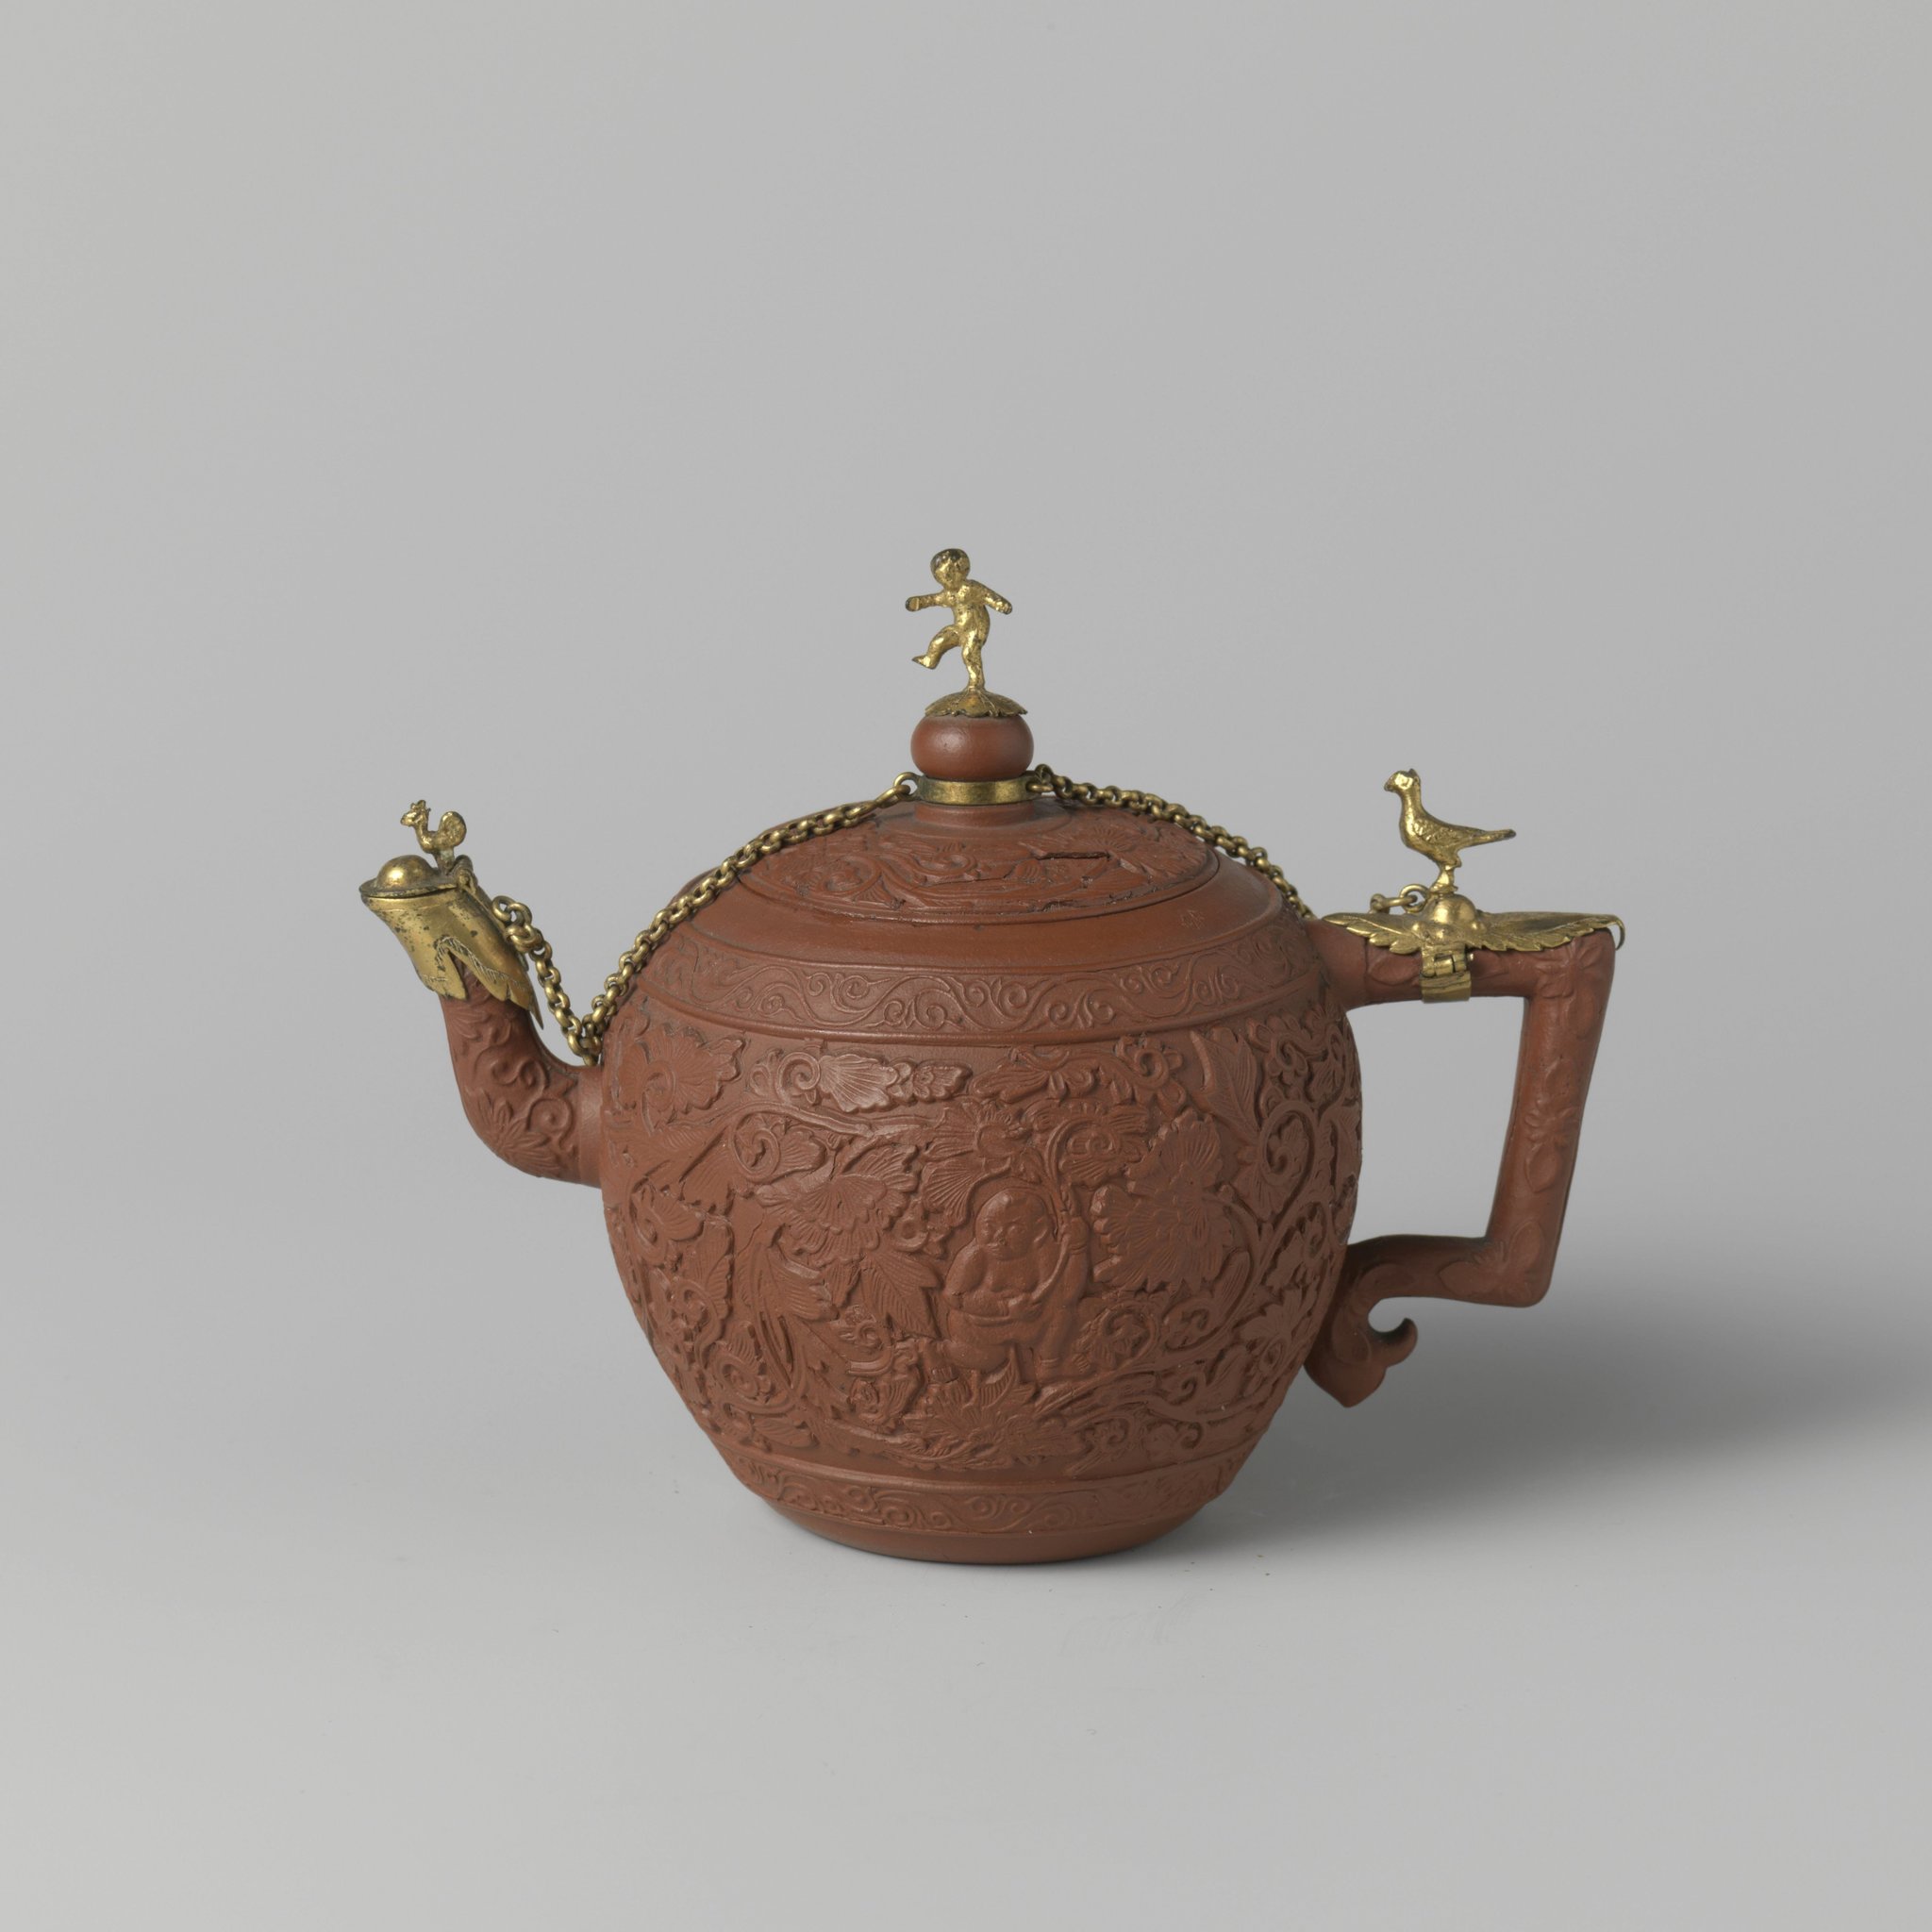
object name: teapot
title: Teapot with a boy among floral scrolls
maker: Anonymous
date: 1675-1699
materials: bronze, stoneware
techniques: firing, gilding, relief, turning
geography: china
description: A boy amidst flowers and foliage is a Buddhist motif that enjoyed popularity during the Song Dynasty (960-1279). After this teapot landed in Europe in the 17th century, it was fitted with the gilt-bronze chain and ornaments. In the process, the miniature figure atop the cover was made to mimic the little boy in the original decoration on the pot’s body.